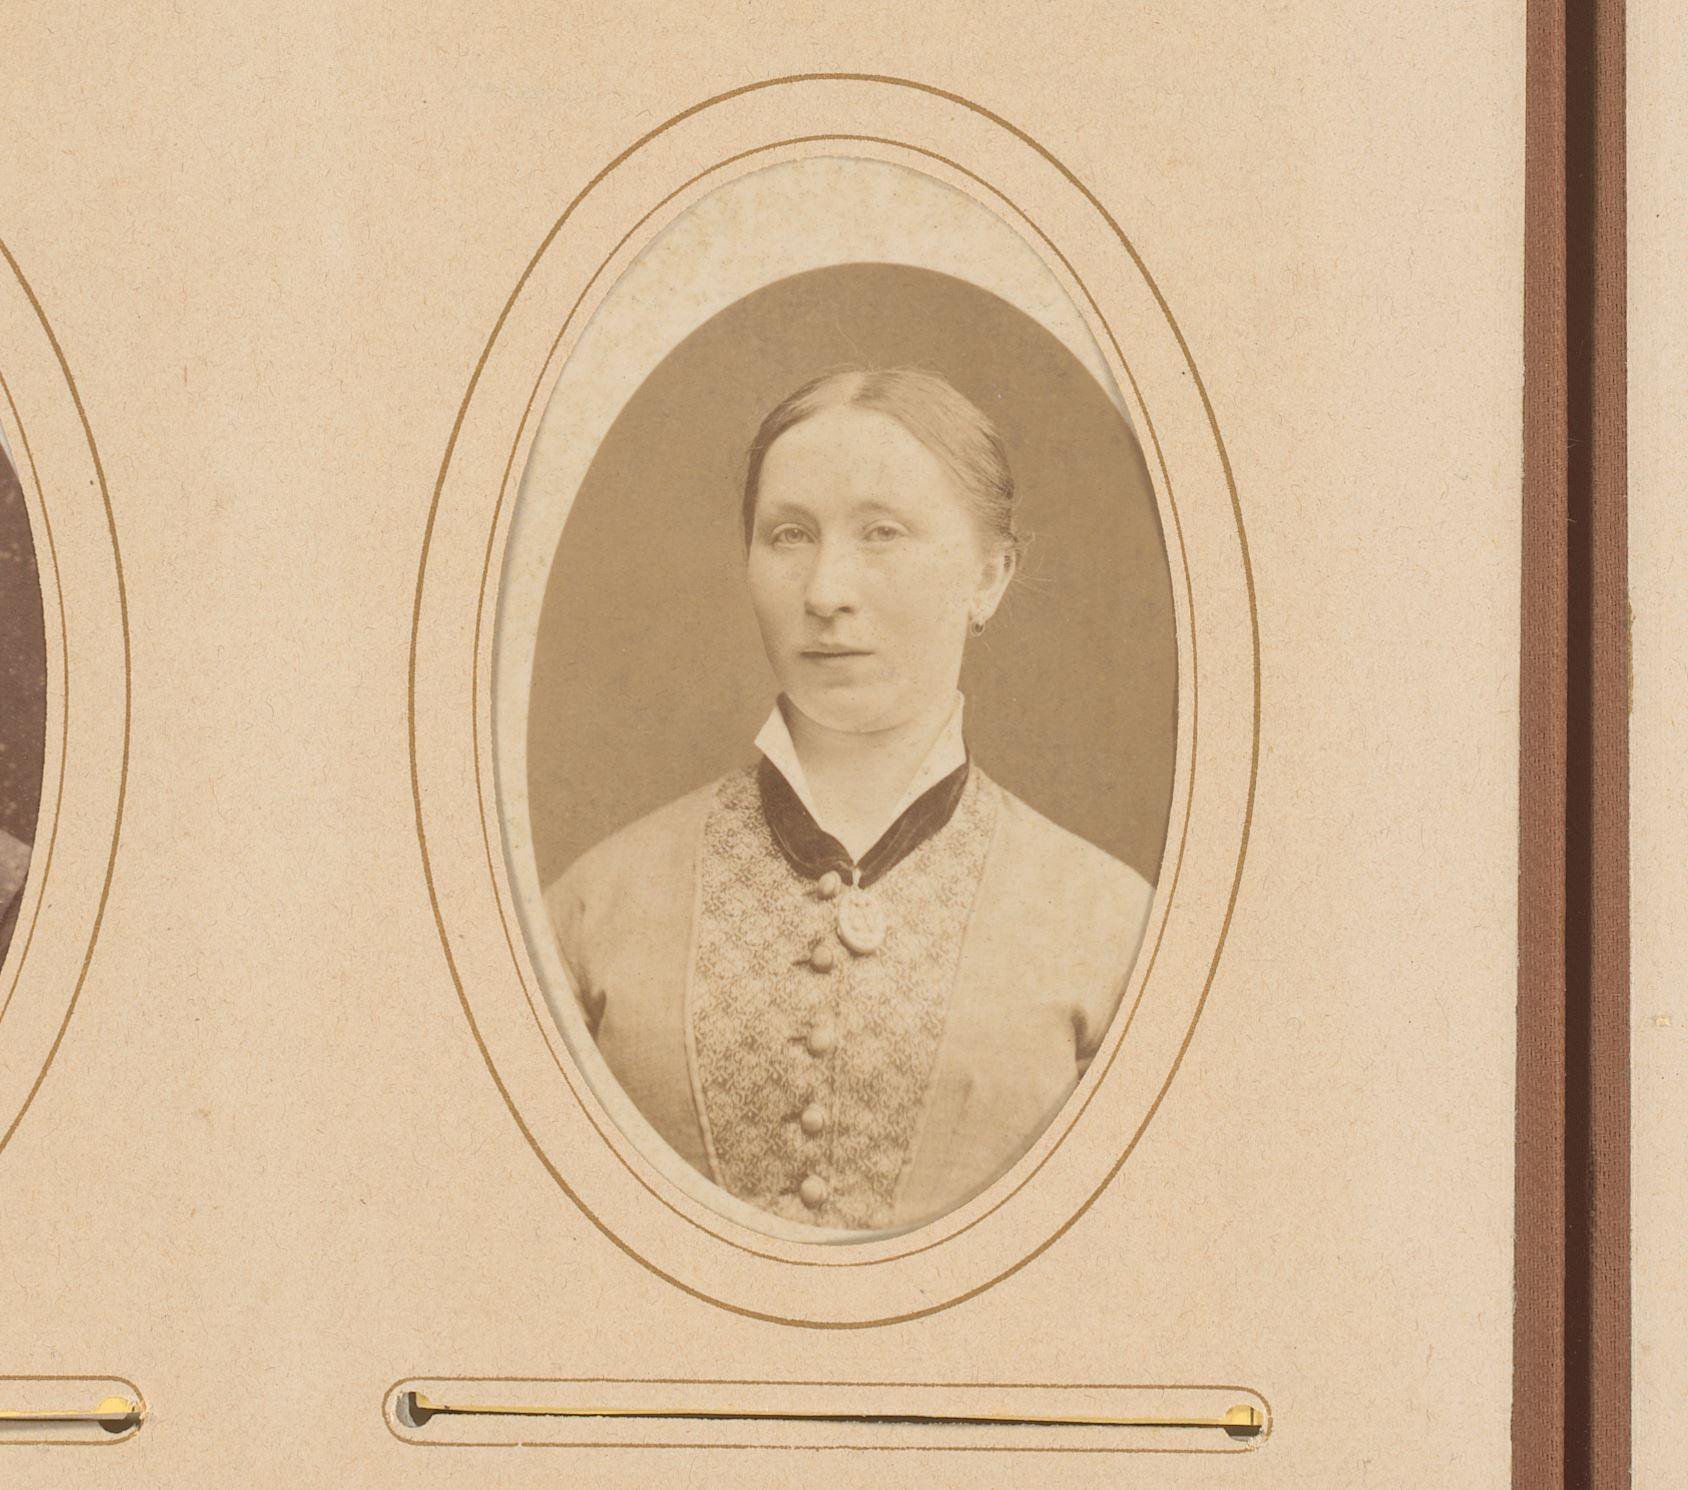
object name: photograph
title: Portret van een jonge vrouw met medaillon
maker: friedrich julius von kolkow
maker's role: fotograaf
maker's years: 1839-1914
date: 1879-1900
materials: cardboard, photographic support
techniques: albumen print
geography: groningen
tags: historical persons - bb - woman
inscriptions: inscription: ‘(...) Fr. Jul. von Kolkow/ Hof-Photograaf/ van Z.M. den Koning/ en wylen Z.K.H. Prins Hendrik der Nederlanden / Groningen’